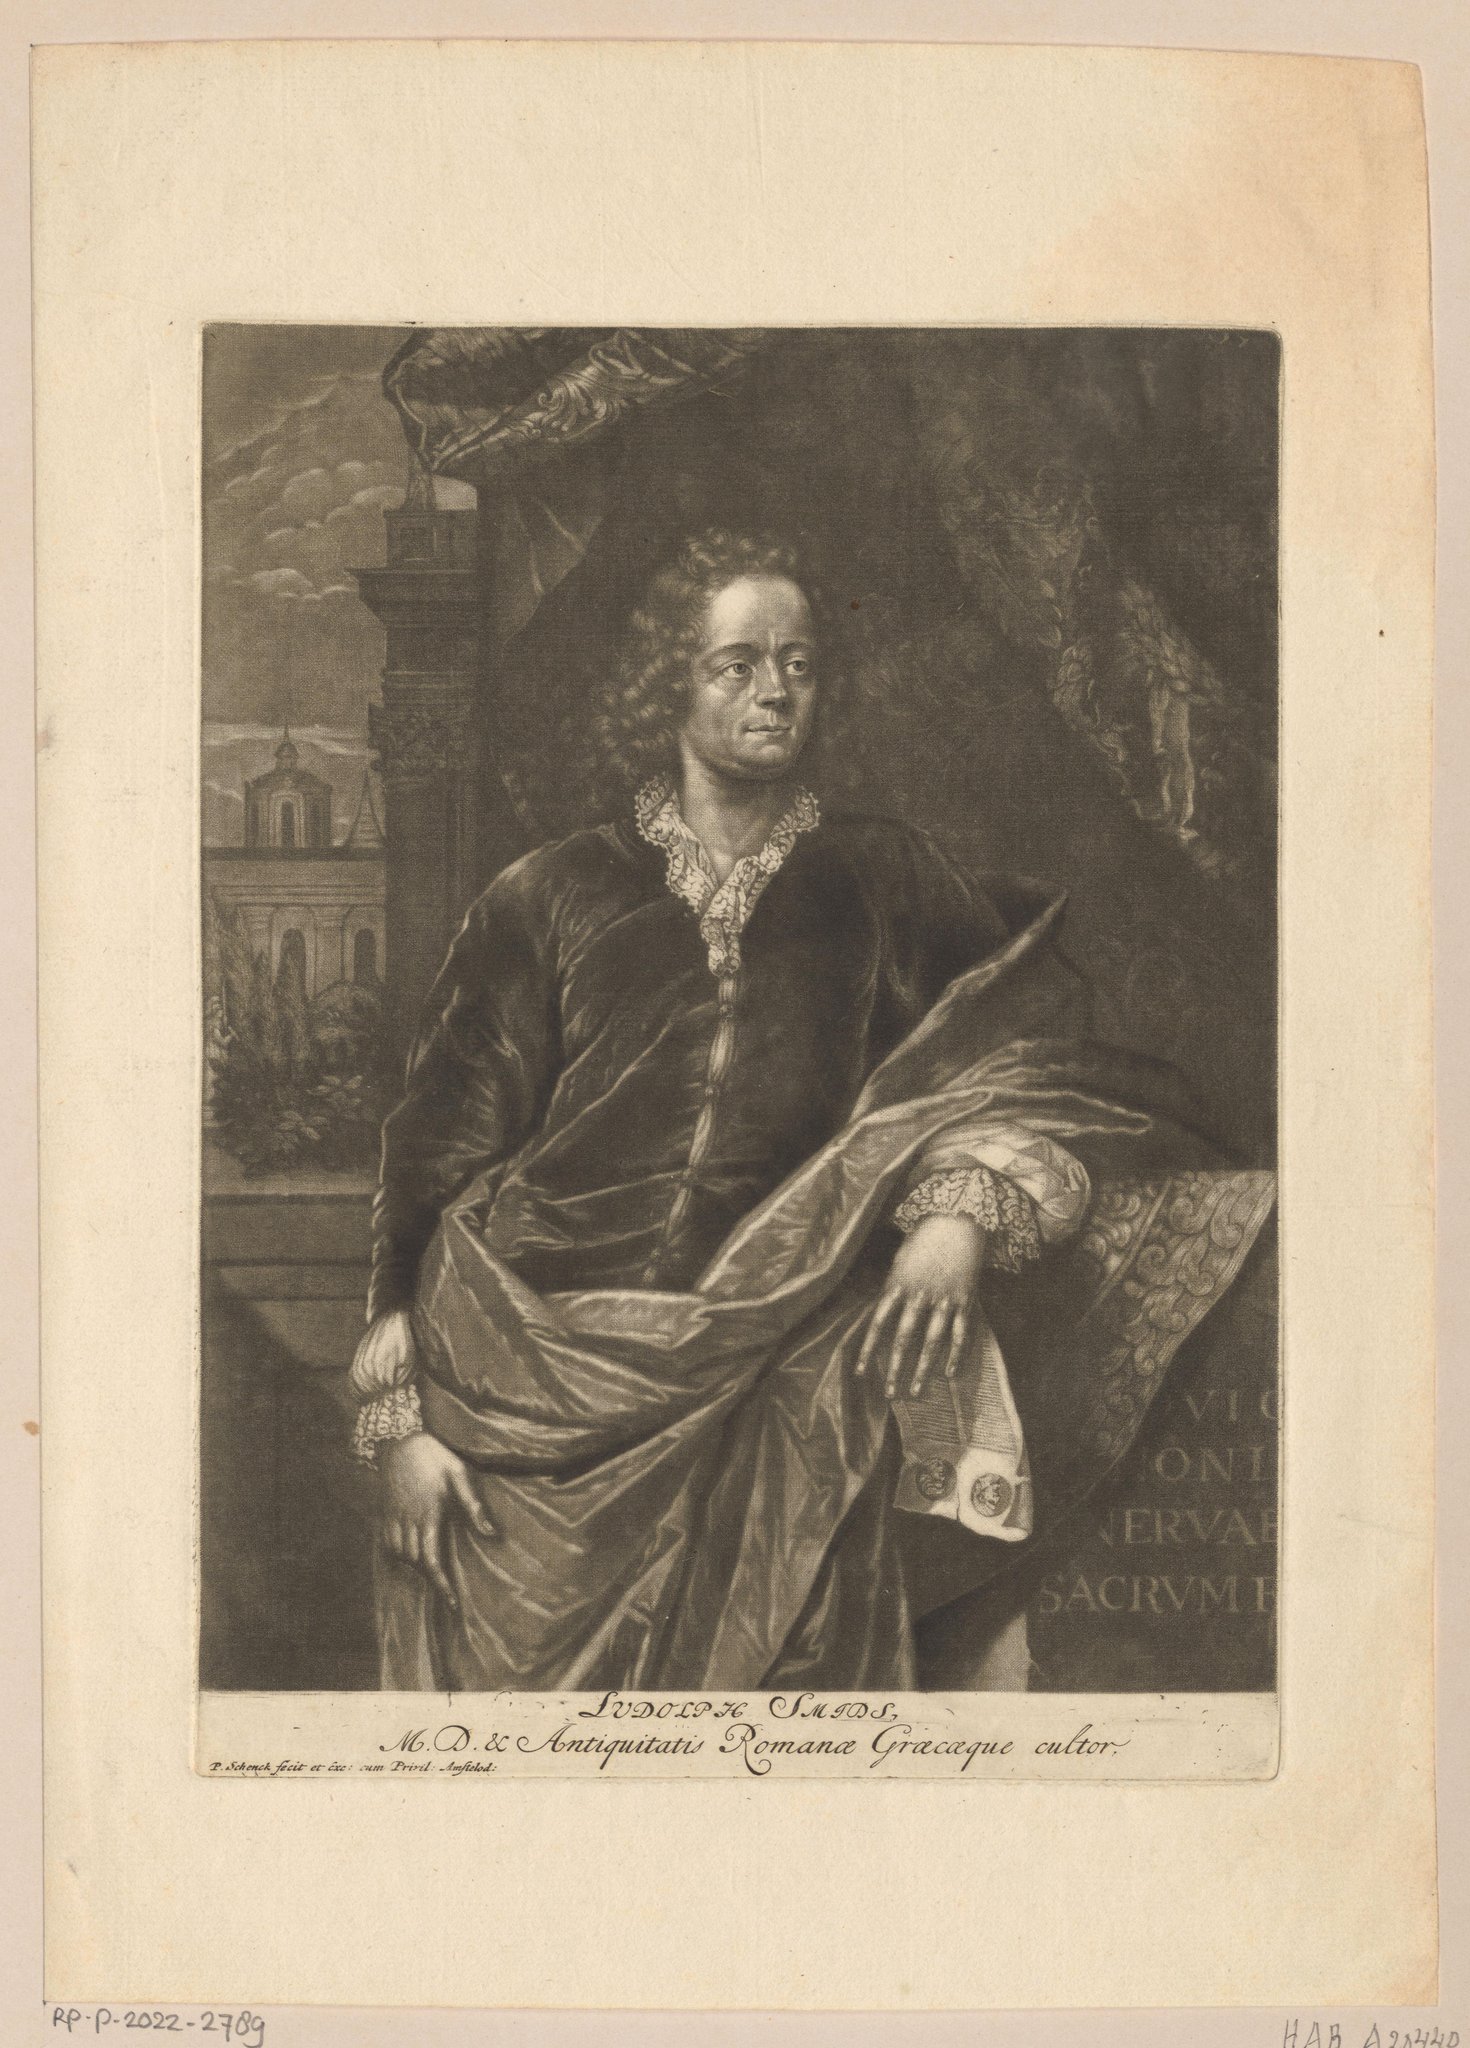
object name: print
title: Portret van Ludolph Smids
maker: pieter schenk (i)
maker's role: print maker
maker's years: 1660-1711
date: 1679-1713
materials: paper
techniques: engraving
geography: amsterdam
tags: amsterdam, ludolph smids, historical persons, portrait of a writer, writer, poet, author, physician, doctor (+ portrait of scholar, scientist)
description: Met eenregelig onderschrift in het Latijn.